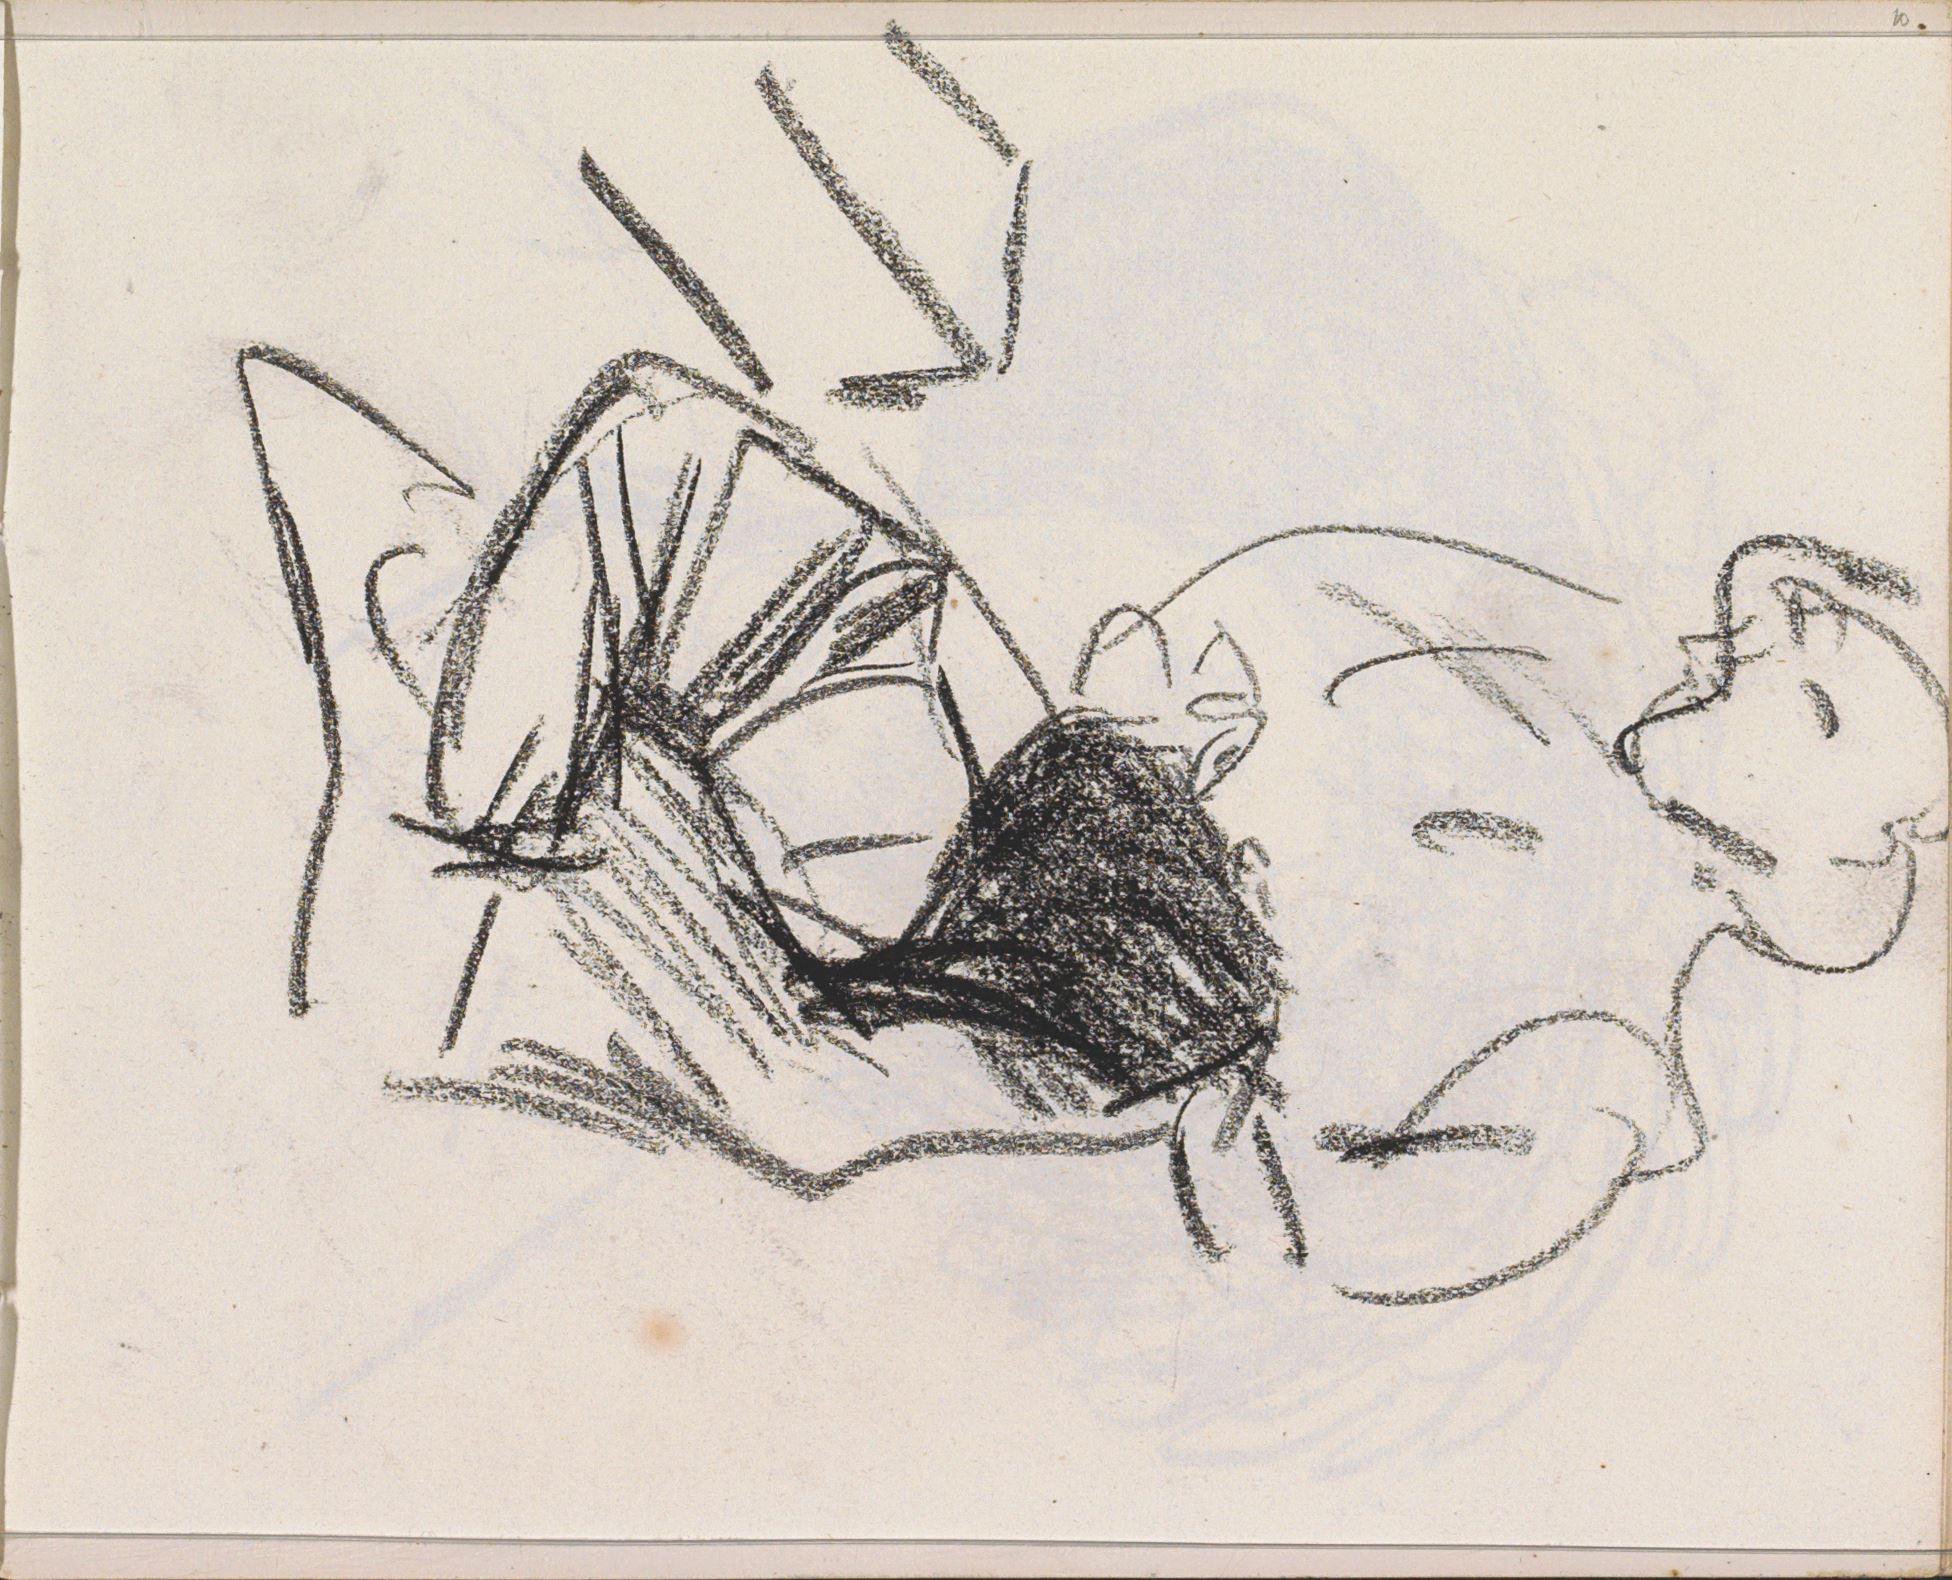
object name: sketchbook leaf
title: Zittende vrouw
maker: isaac israels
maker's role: draughtsman, painter, print maker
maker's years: 1865-1934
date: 1875-1934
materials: chalk, paper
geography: the hague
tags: adult woman (+ sitting)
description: Mogelijk in kleermakerszit. In haar handen heeft ze een voorwerp. Pagina 10 uit schetsboek XLIII met 61 pagina's.